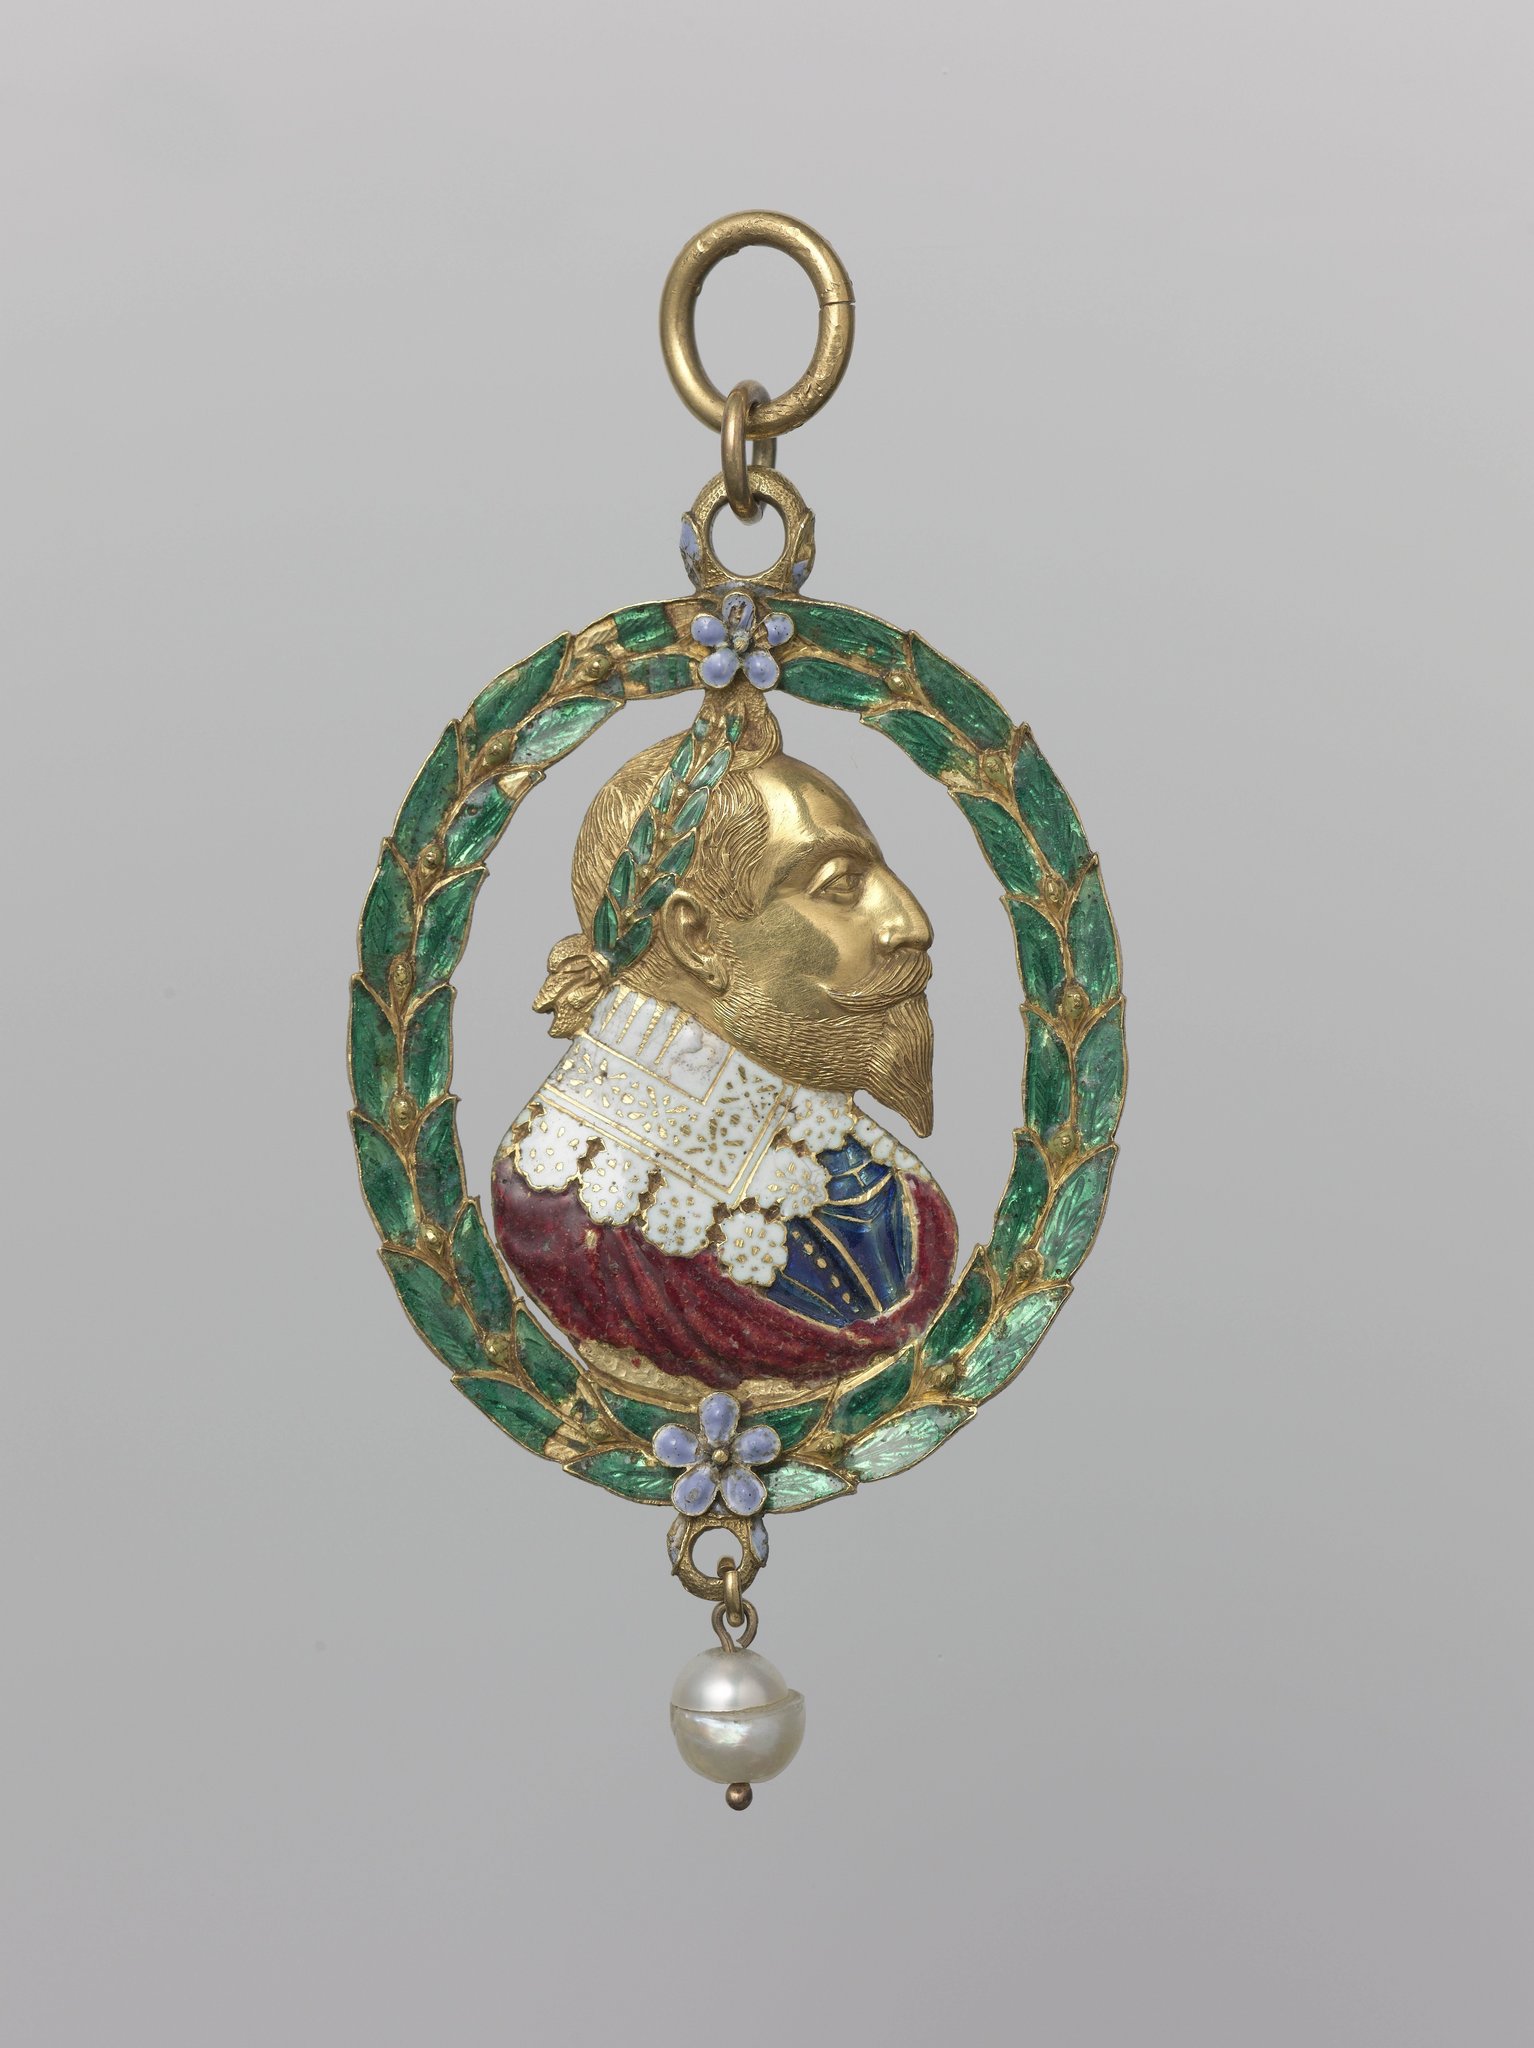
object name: pendant jewelry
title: Hanger van goud en email met borstbeeld Gustaaf Adolf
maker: Anonymous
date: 1632-1635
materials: gold, pearl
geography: germany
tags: stockholm, lützen, koning, gustaaf ii adolf (koning van zweden), zweden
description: Pendant commemorating King Gustav II Adolf of Sweden. Gold, pearl and enamel. Germany, c. 1632-1635.